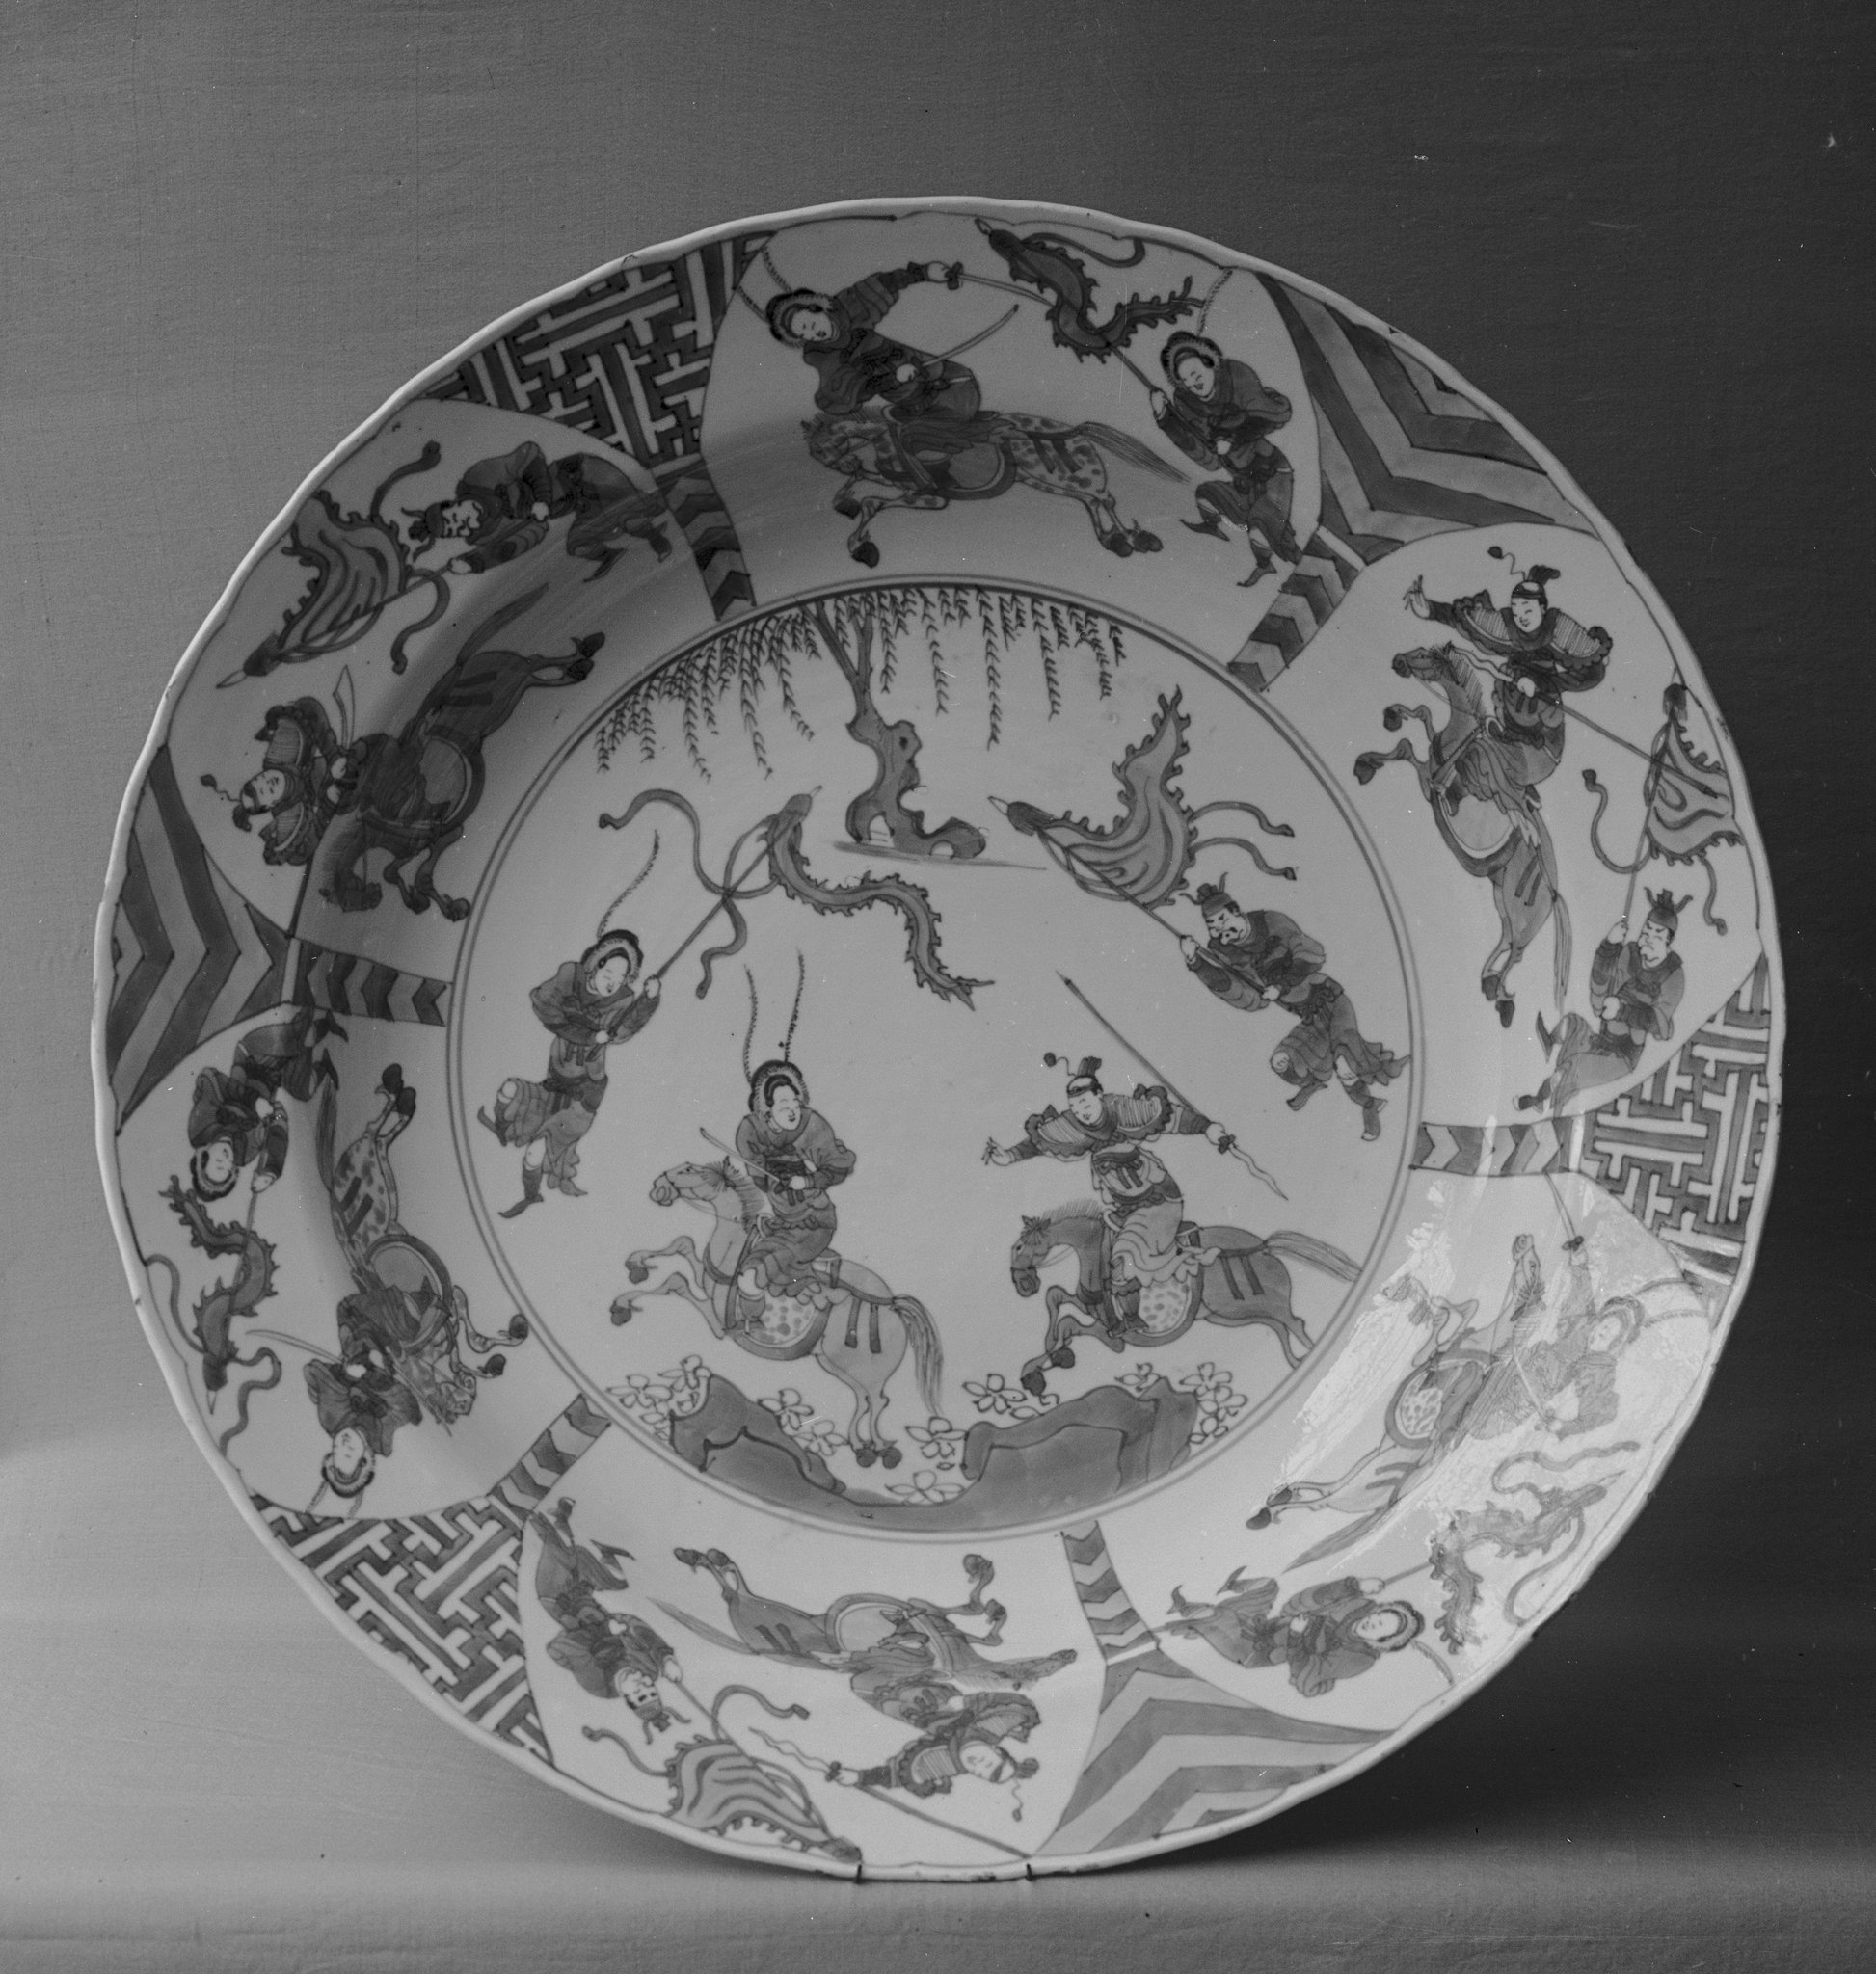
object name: plate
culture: chinese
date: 1667-1733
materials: porcelain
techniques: painting, underglaze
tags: men,horses